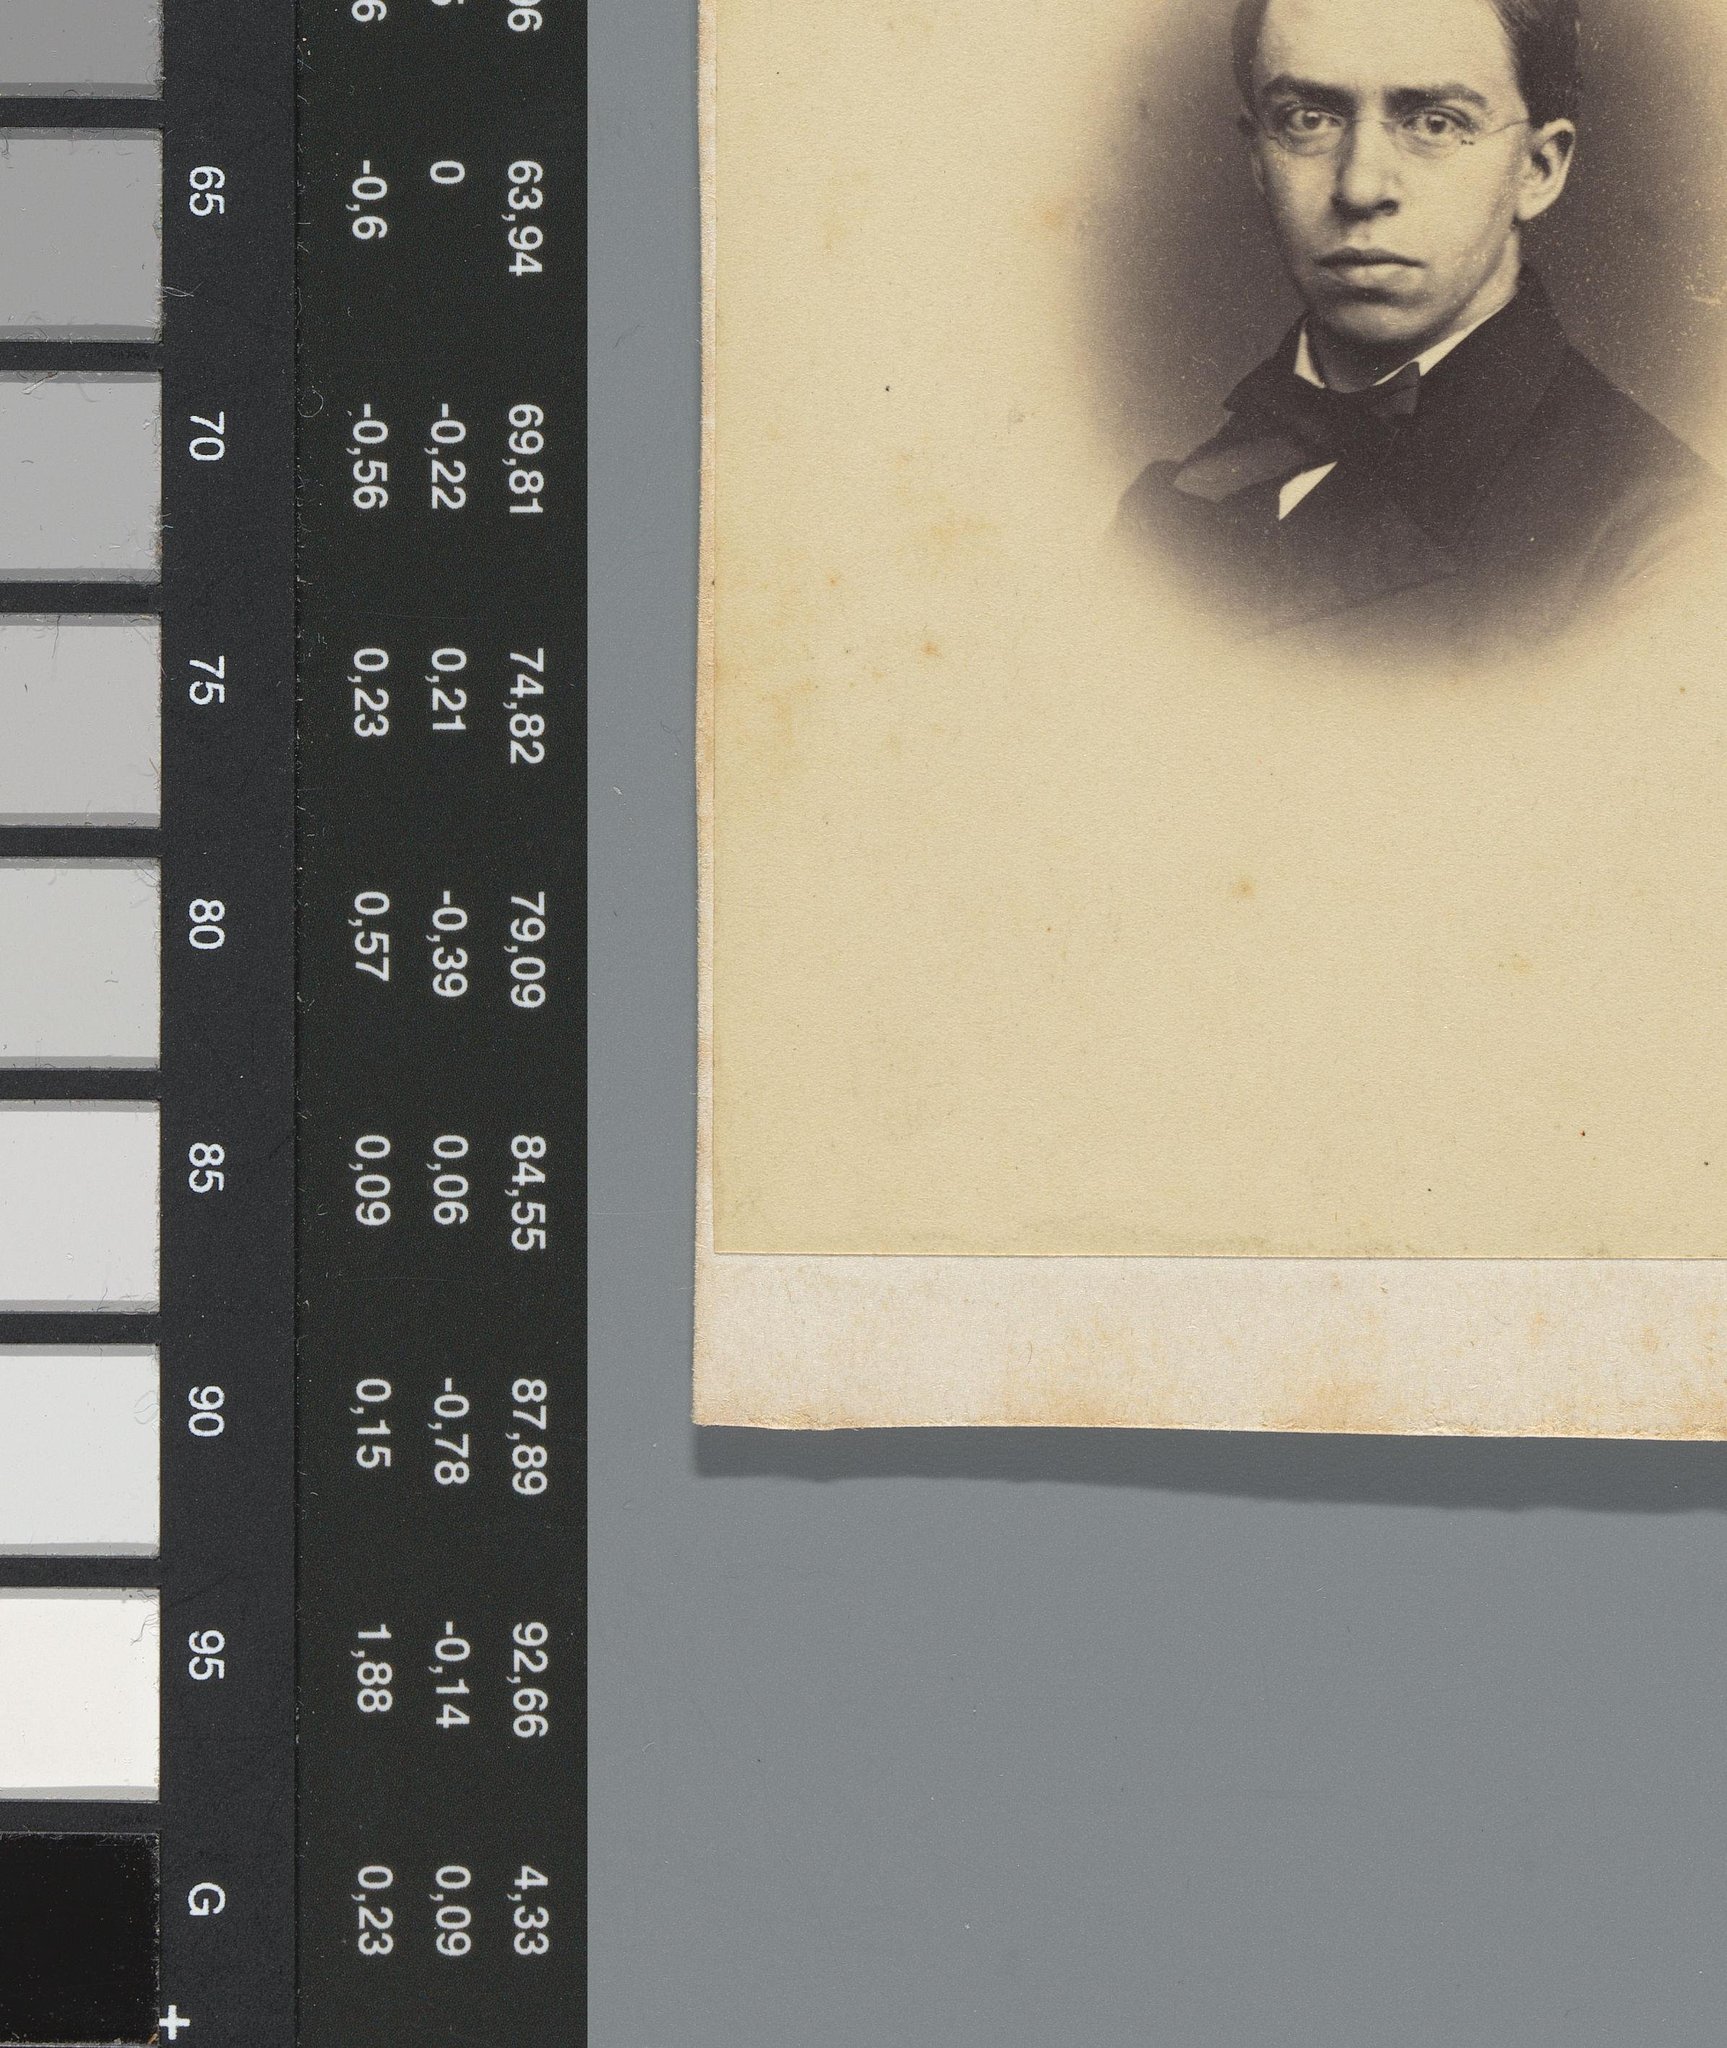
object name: photograph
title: Portret van Petrus Johannes van den Berg (Piet) in ovaal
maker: gerrit hoogwinkel jr.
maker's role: fotograaf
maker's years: 1837-1890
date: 1855-1910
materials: cardboard, photographic support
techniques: albumen print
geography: rotterdam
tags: notaris, petrus johannes van den berg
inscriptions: name: ‘G. HOOGWINKEL / PHOTOGRAPHE / ROTTERDAM’, inscription: ‘oom Piet v. d. Berg / 1835 - 1892 / Notaris in / Rotterdam’